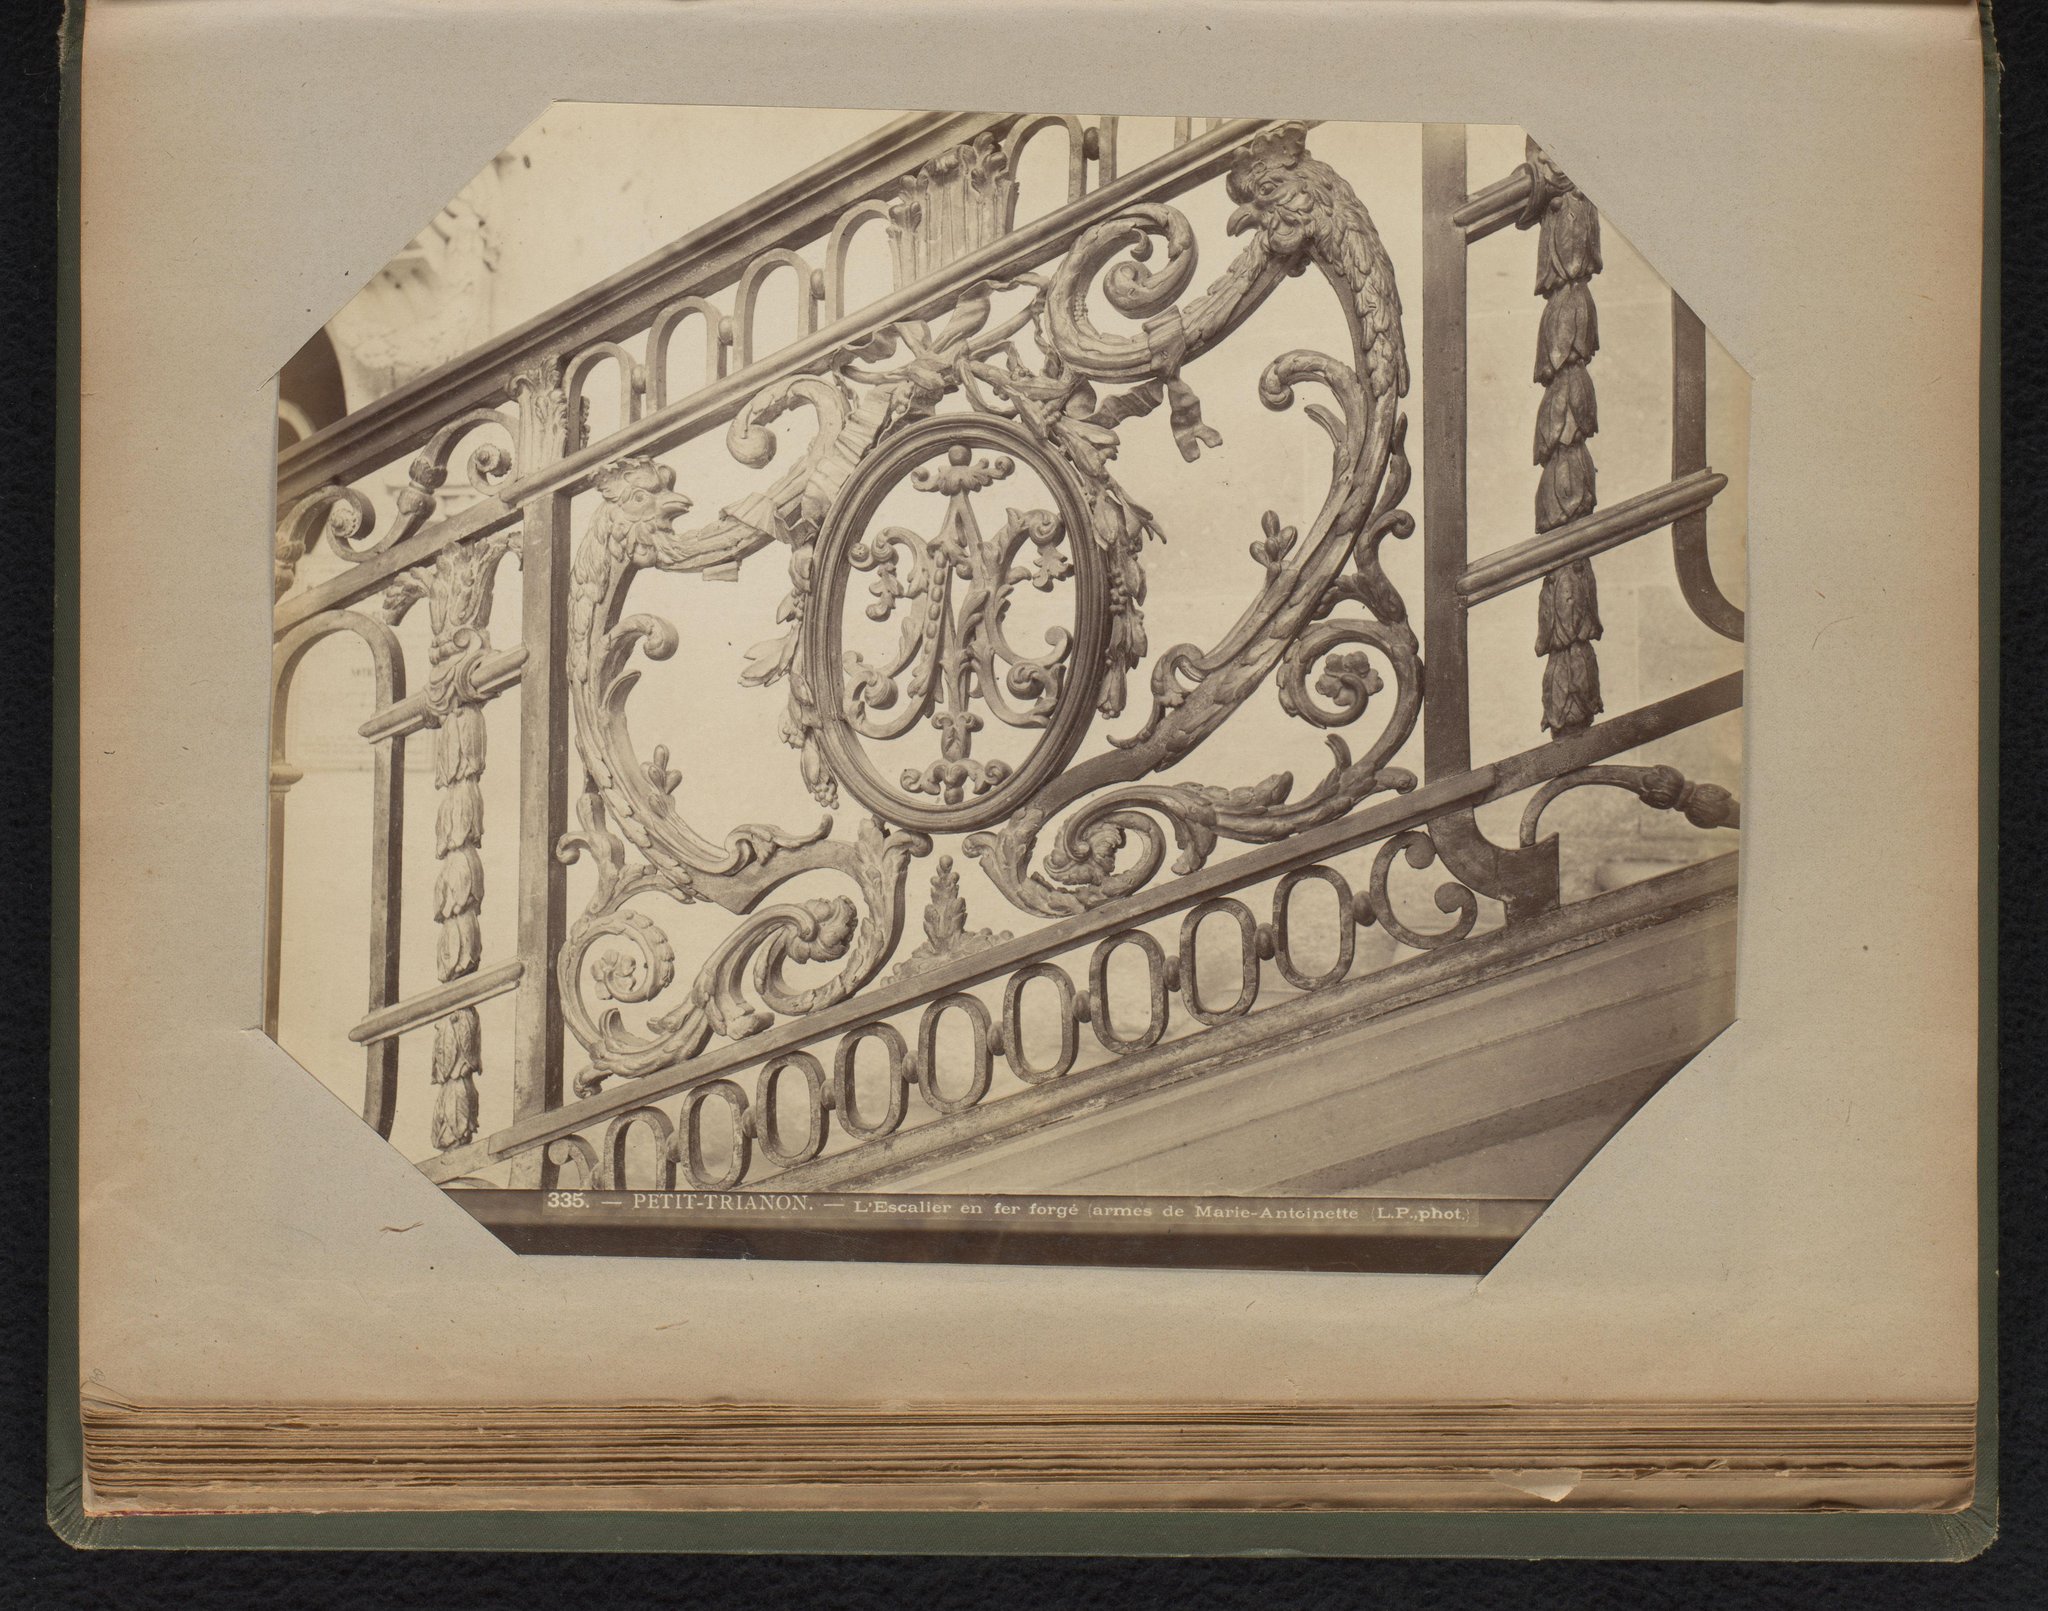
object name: photograph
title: 335. - Petit-Trianon - L'Escalier en fer forgé (armes de Marie Antoinette) (L.P. Phot).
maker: Anonymous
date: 1860-1900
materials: paper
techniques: albumen print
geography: france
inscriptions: annotation: ‘335. - Petit-Trianon - L'Escalier en fer forgé (armes de Marie Antoinette) (L.P. Phot).’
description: Onderdeel van een serie met betrekking tot het interieur van het paleis van Versailles met kroonluchters, deuren, portalen en meubelstukken.